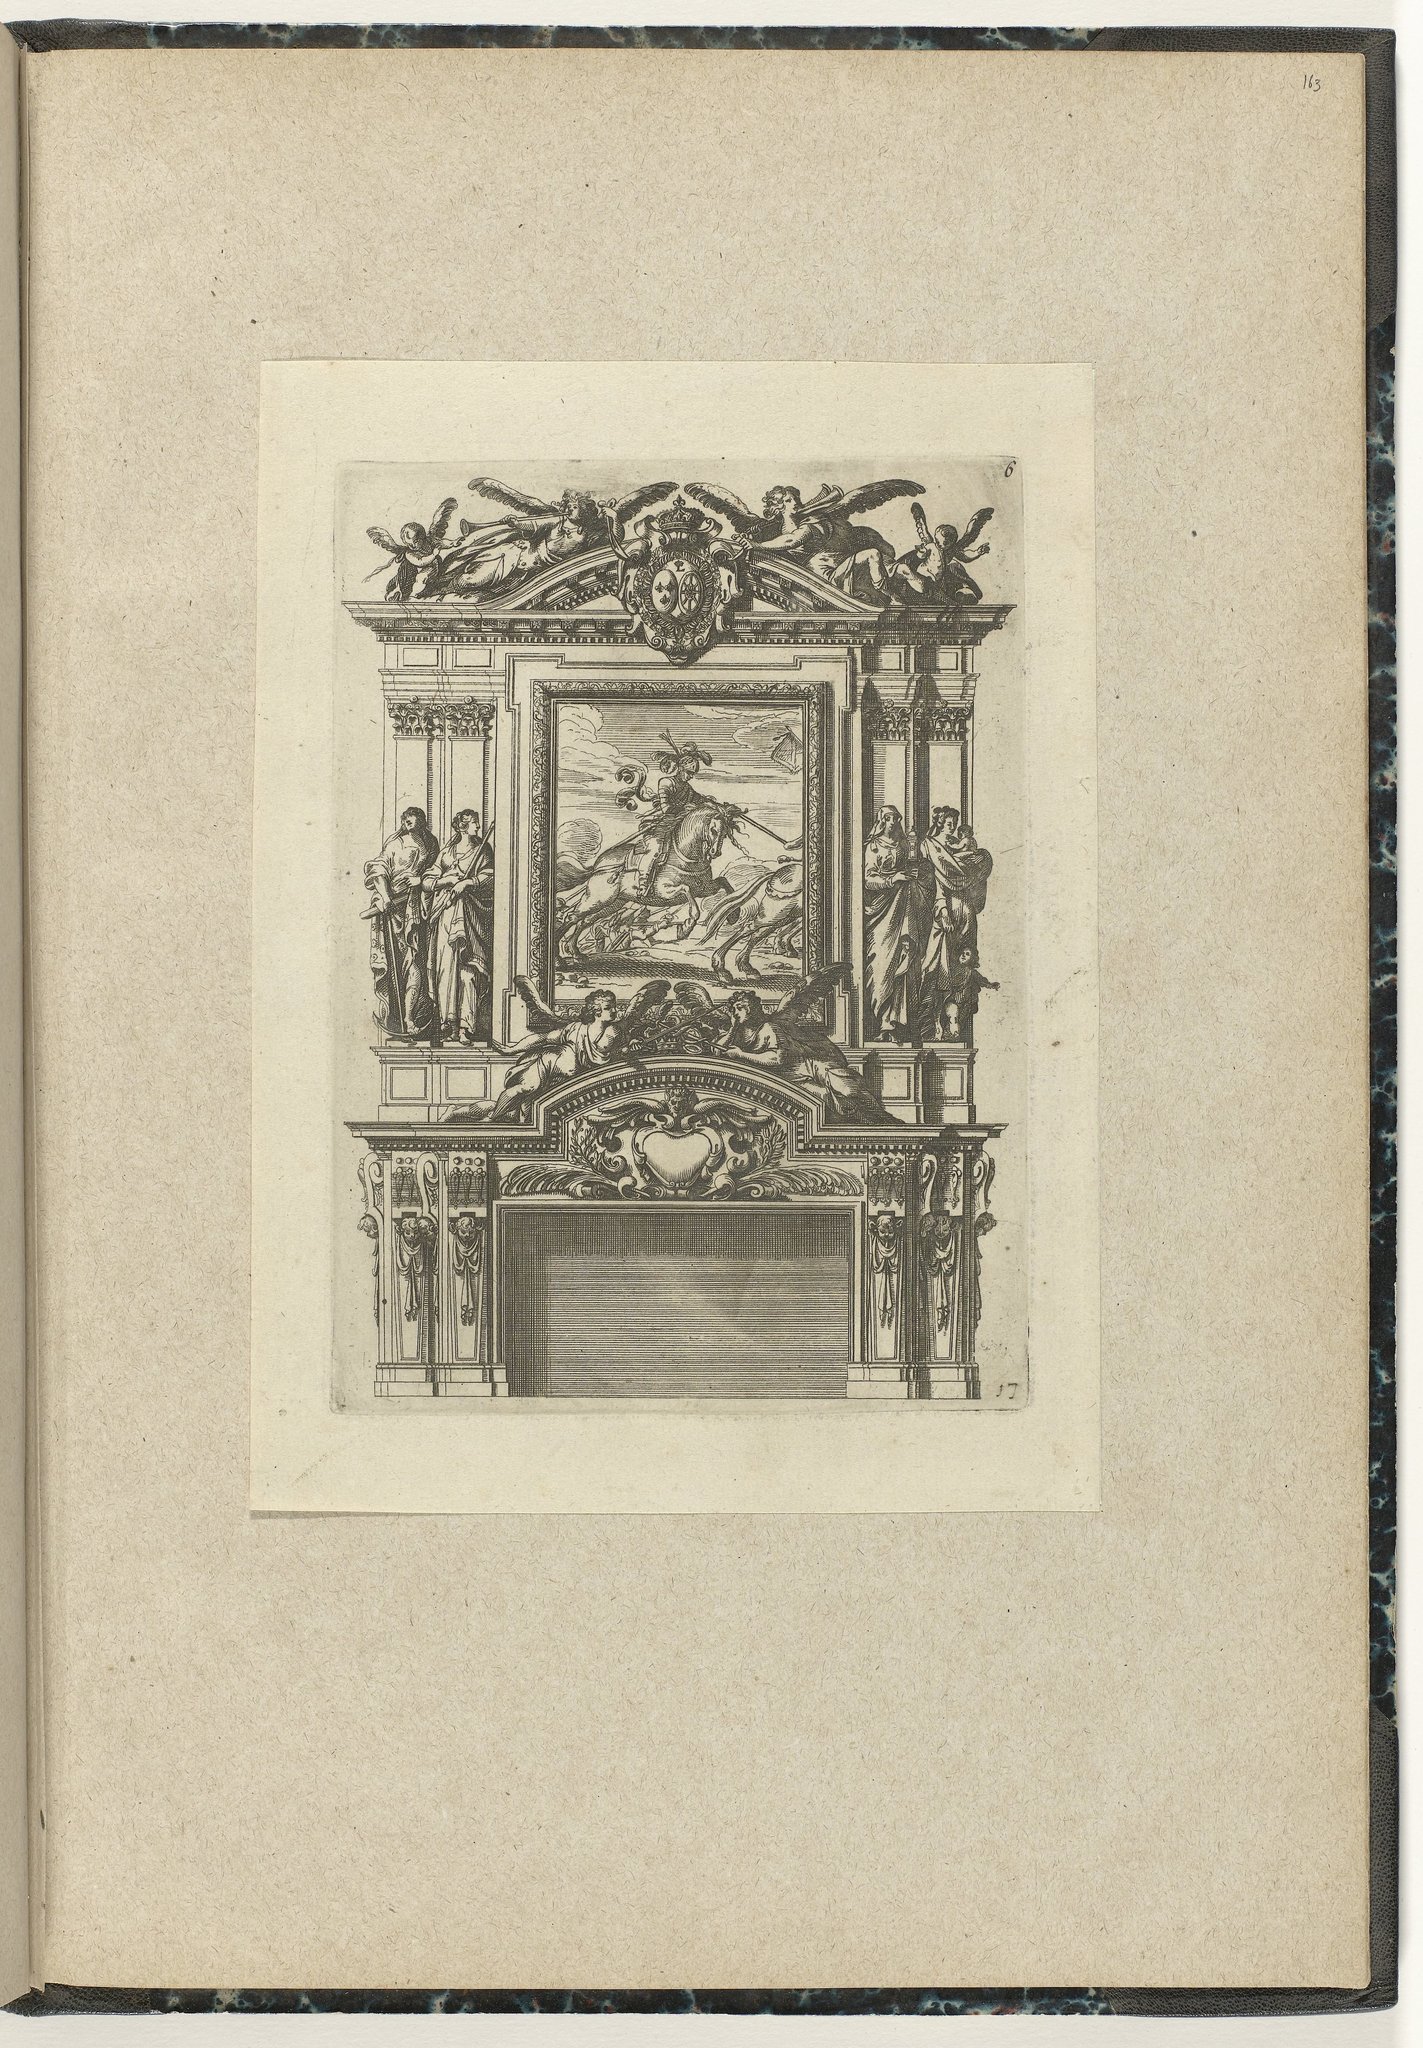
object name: print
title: Onderboezem, schacht gedecoreerd met ridder te paard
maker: Anonymous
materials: paper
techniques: etching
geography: france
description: Rechtsboven staat het getal 6, rechtsonder het getal 17.